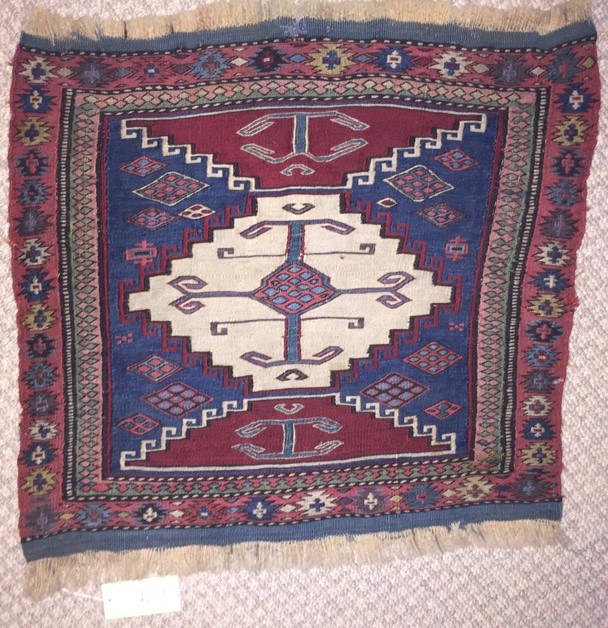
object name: saddle bag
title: Shahsevan Saddle Bag Face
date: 1850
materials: cotton, wool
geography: iran